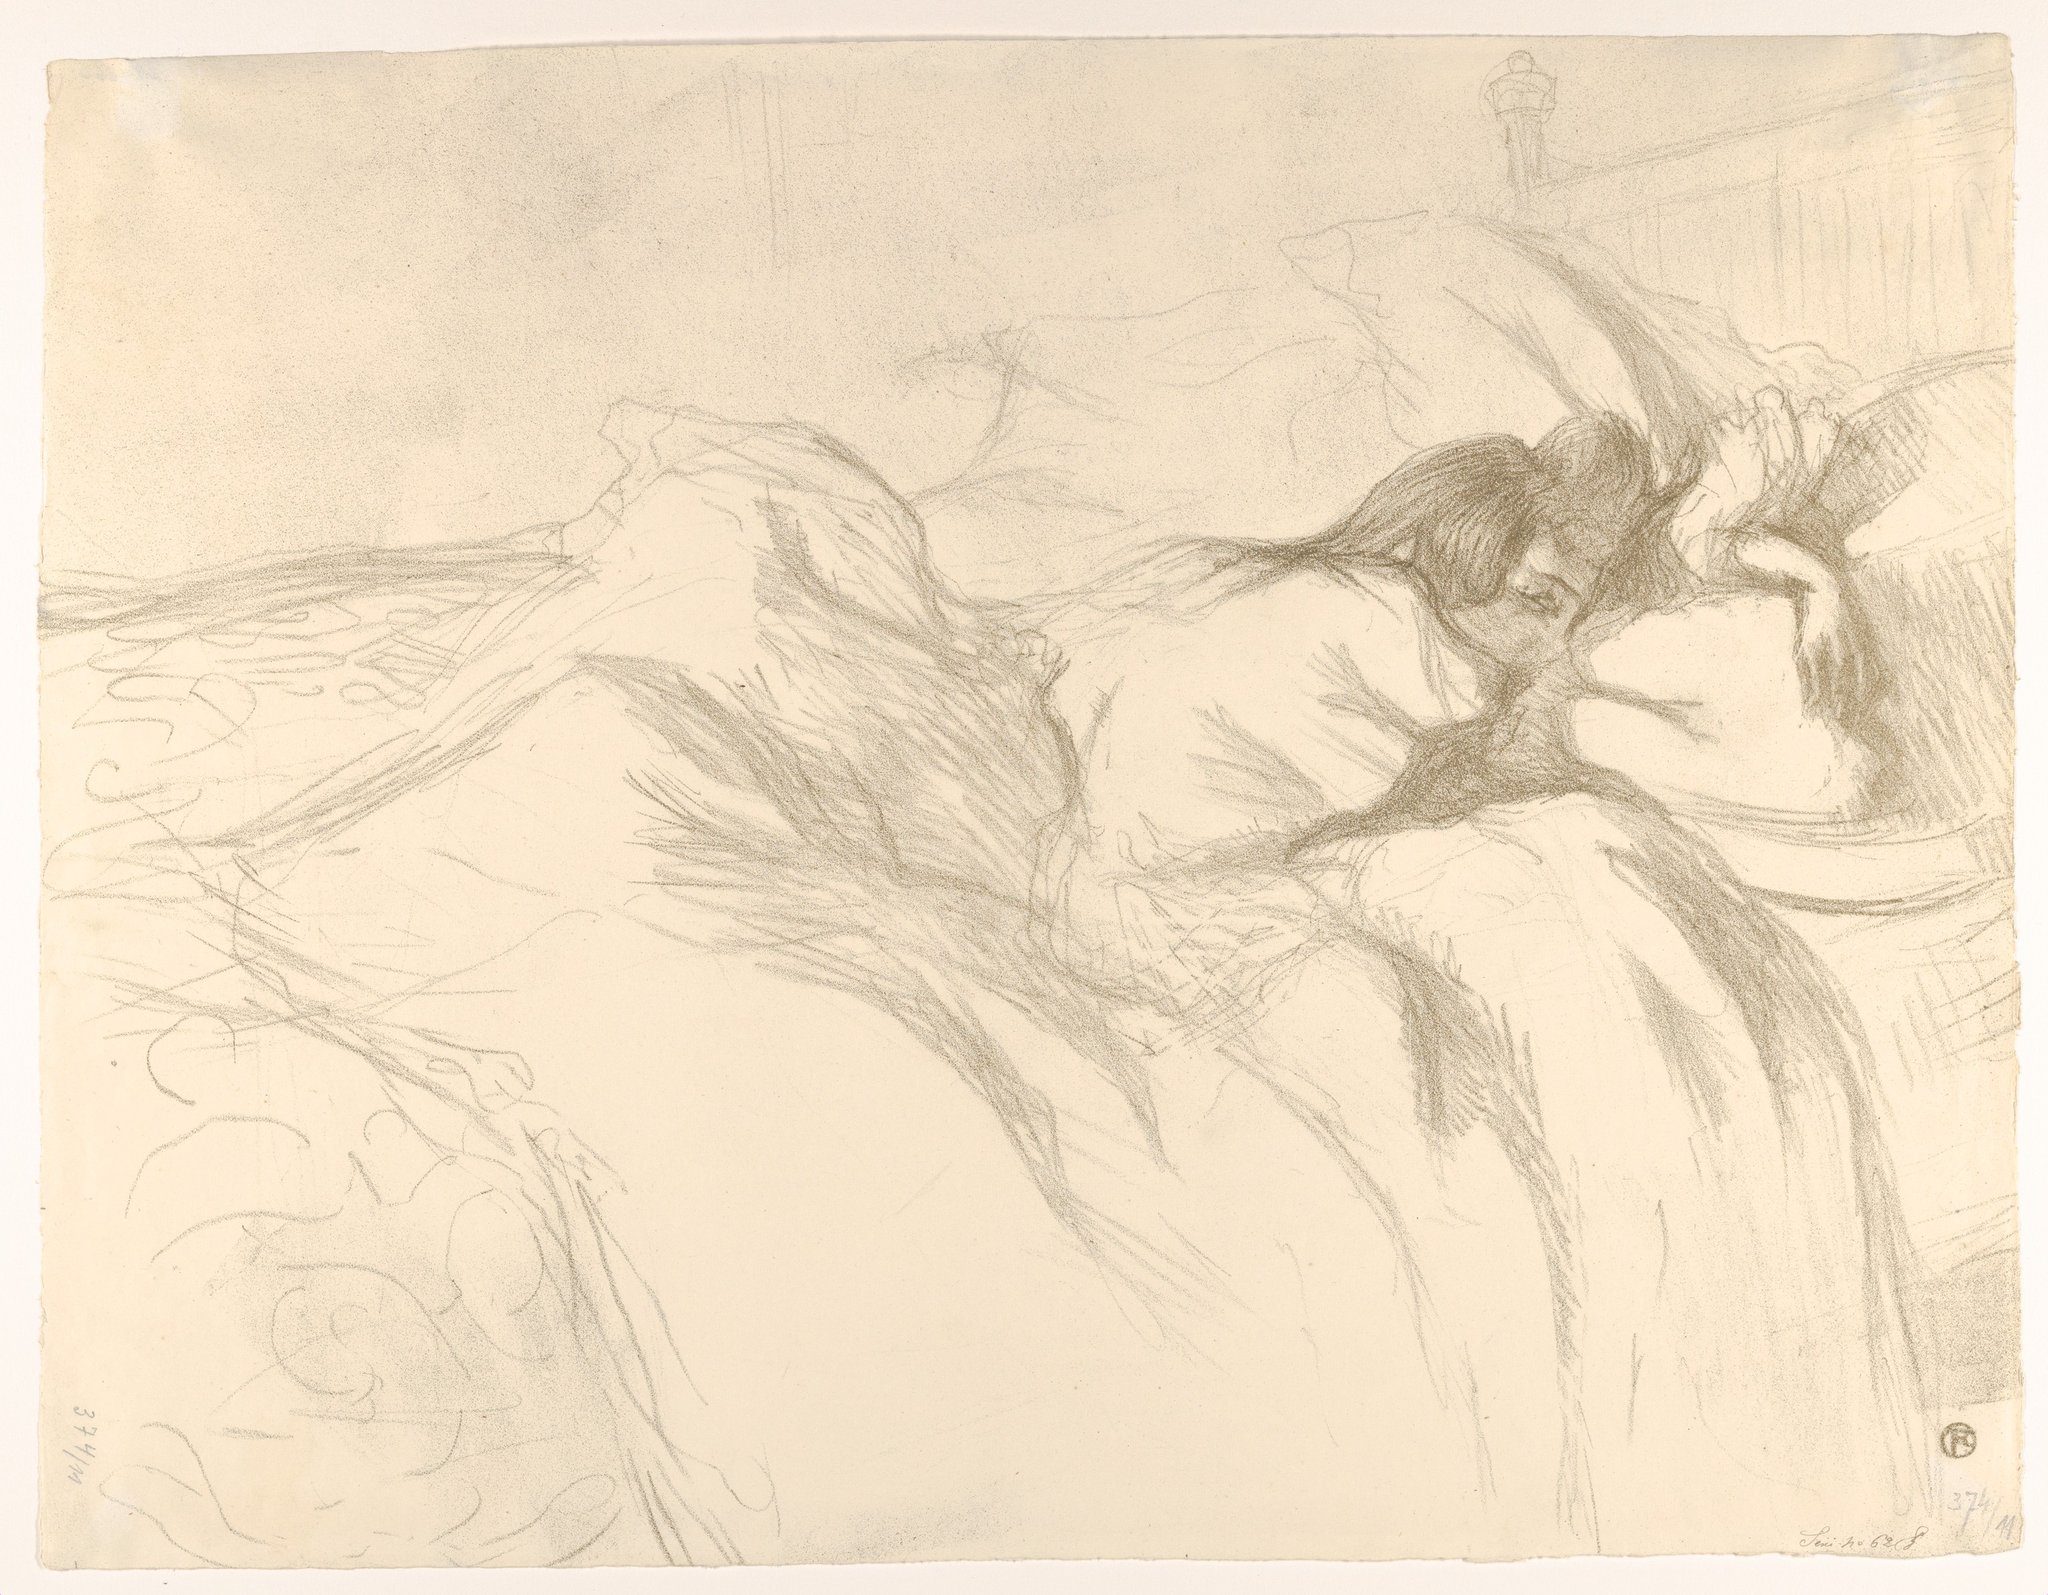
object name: print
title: Waking Up, from "Elles"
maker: henri de toulouse-lautrec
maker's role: artist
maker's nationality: french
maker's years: 1864-1901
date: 1896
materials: paper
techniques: lithograph, printing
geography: france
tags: sleeping,women